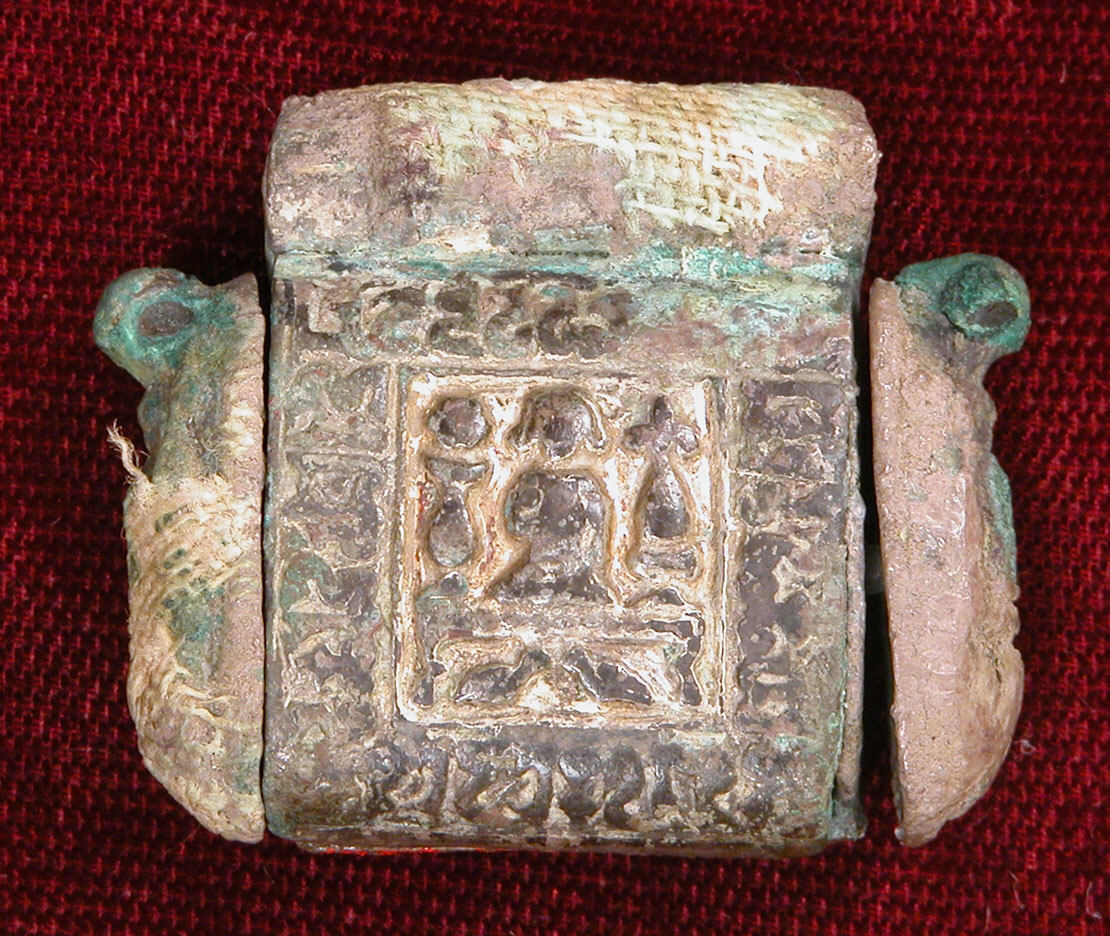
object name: amulet case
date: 1001-1100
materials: niello, silver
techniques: casting, gilding, inlay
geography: iran